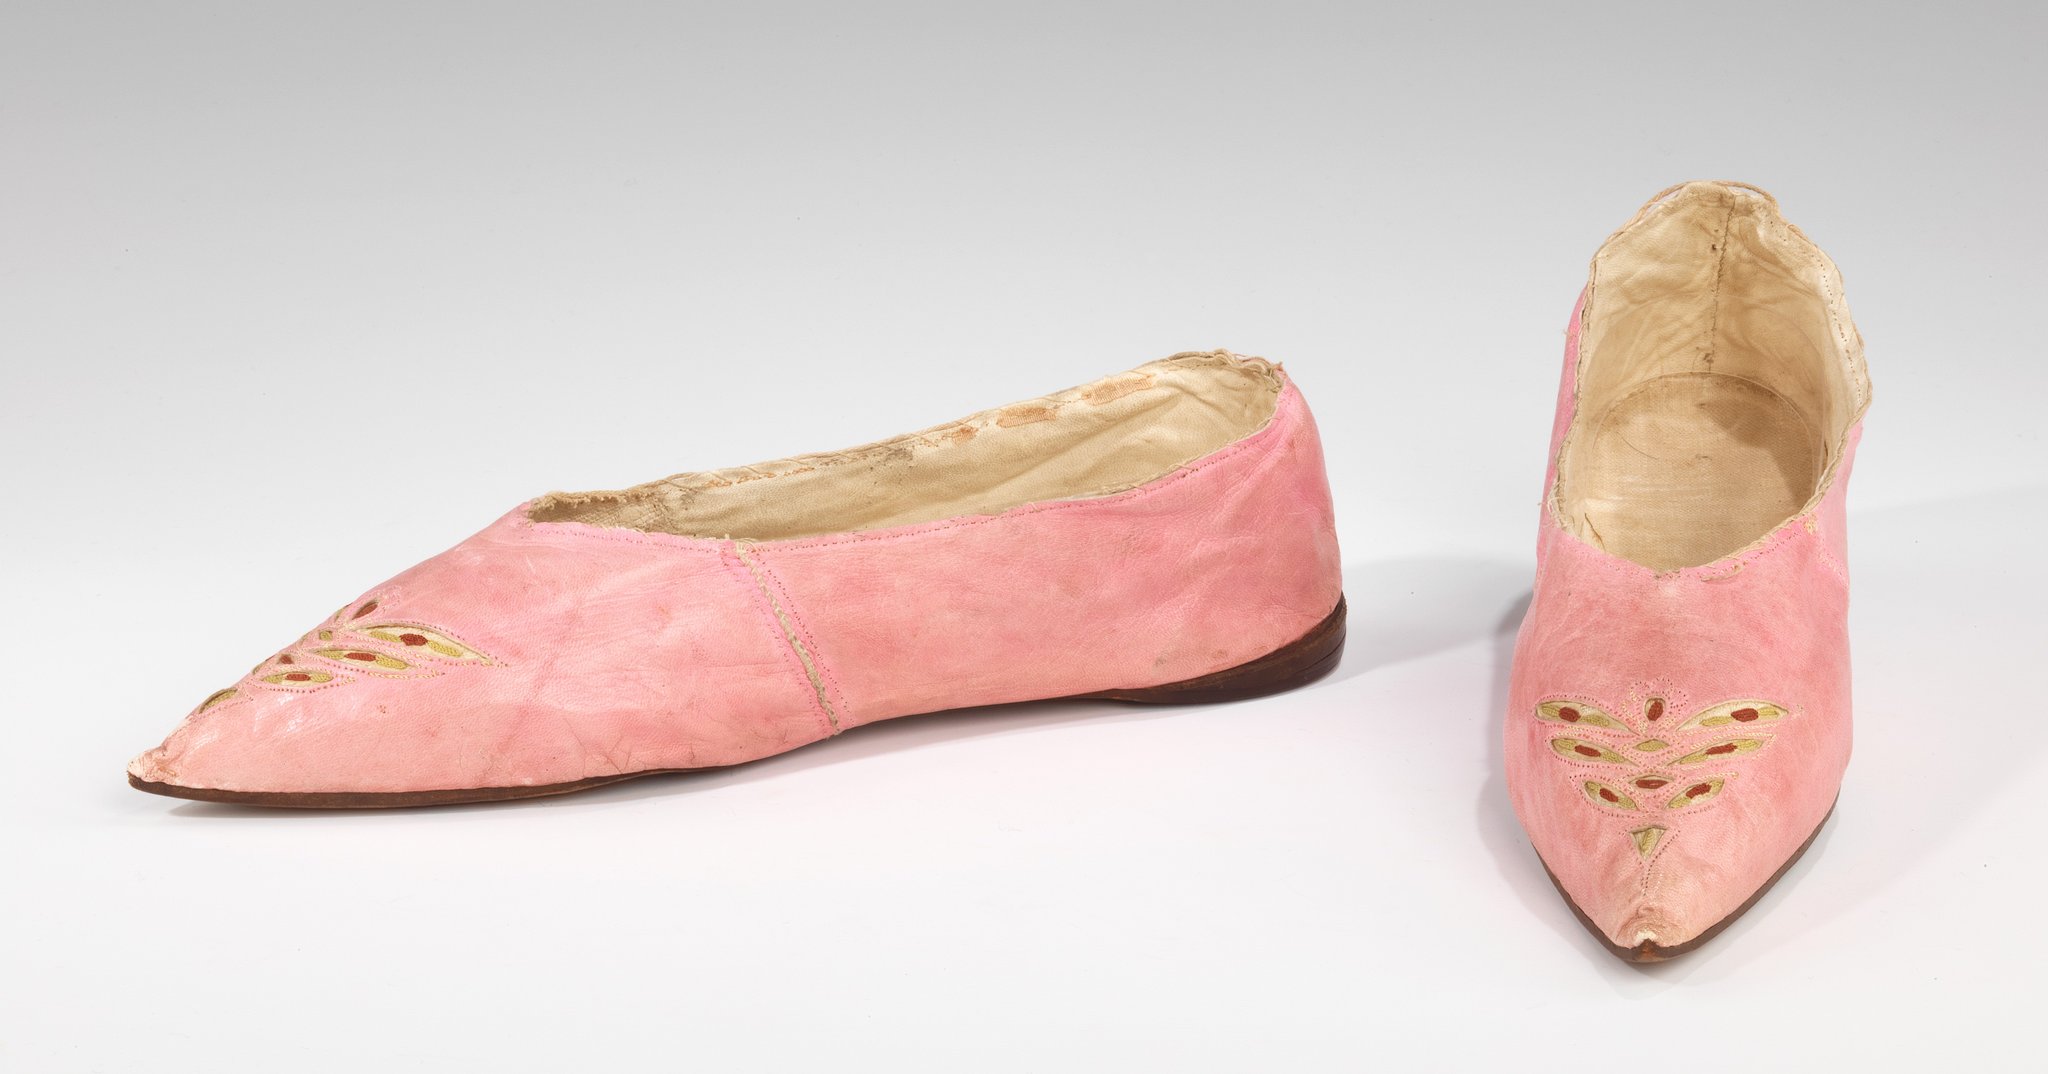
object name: slipper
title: Slippers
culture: european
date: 1795-1810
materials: leather